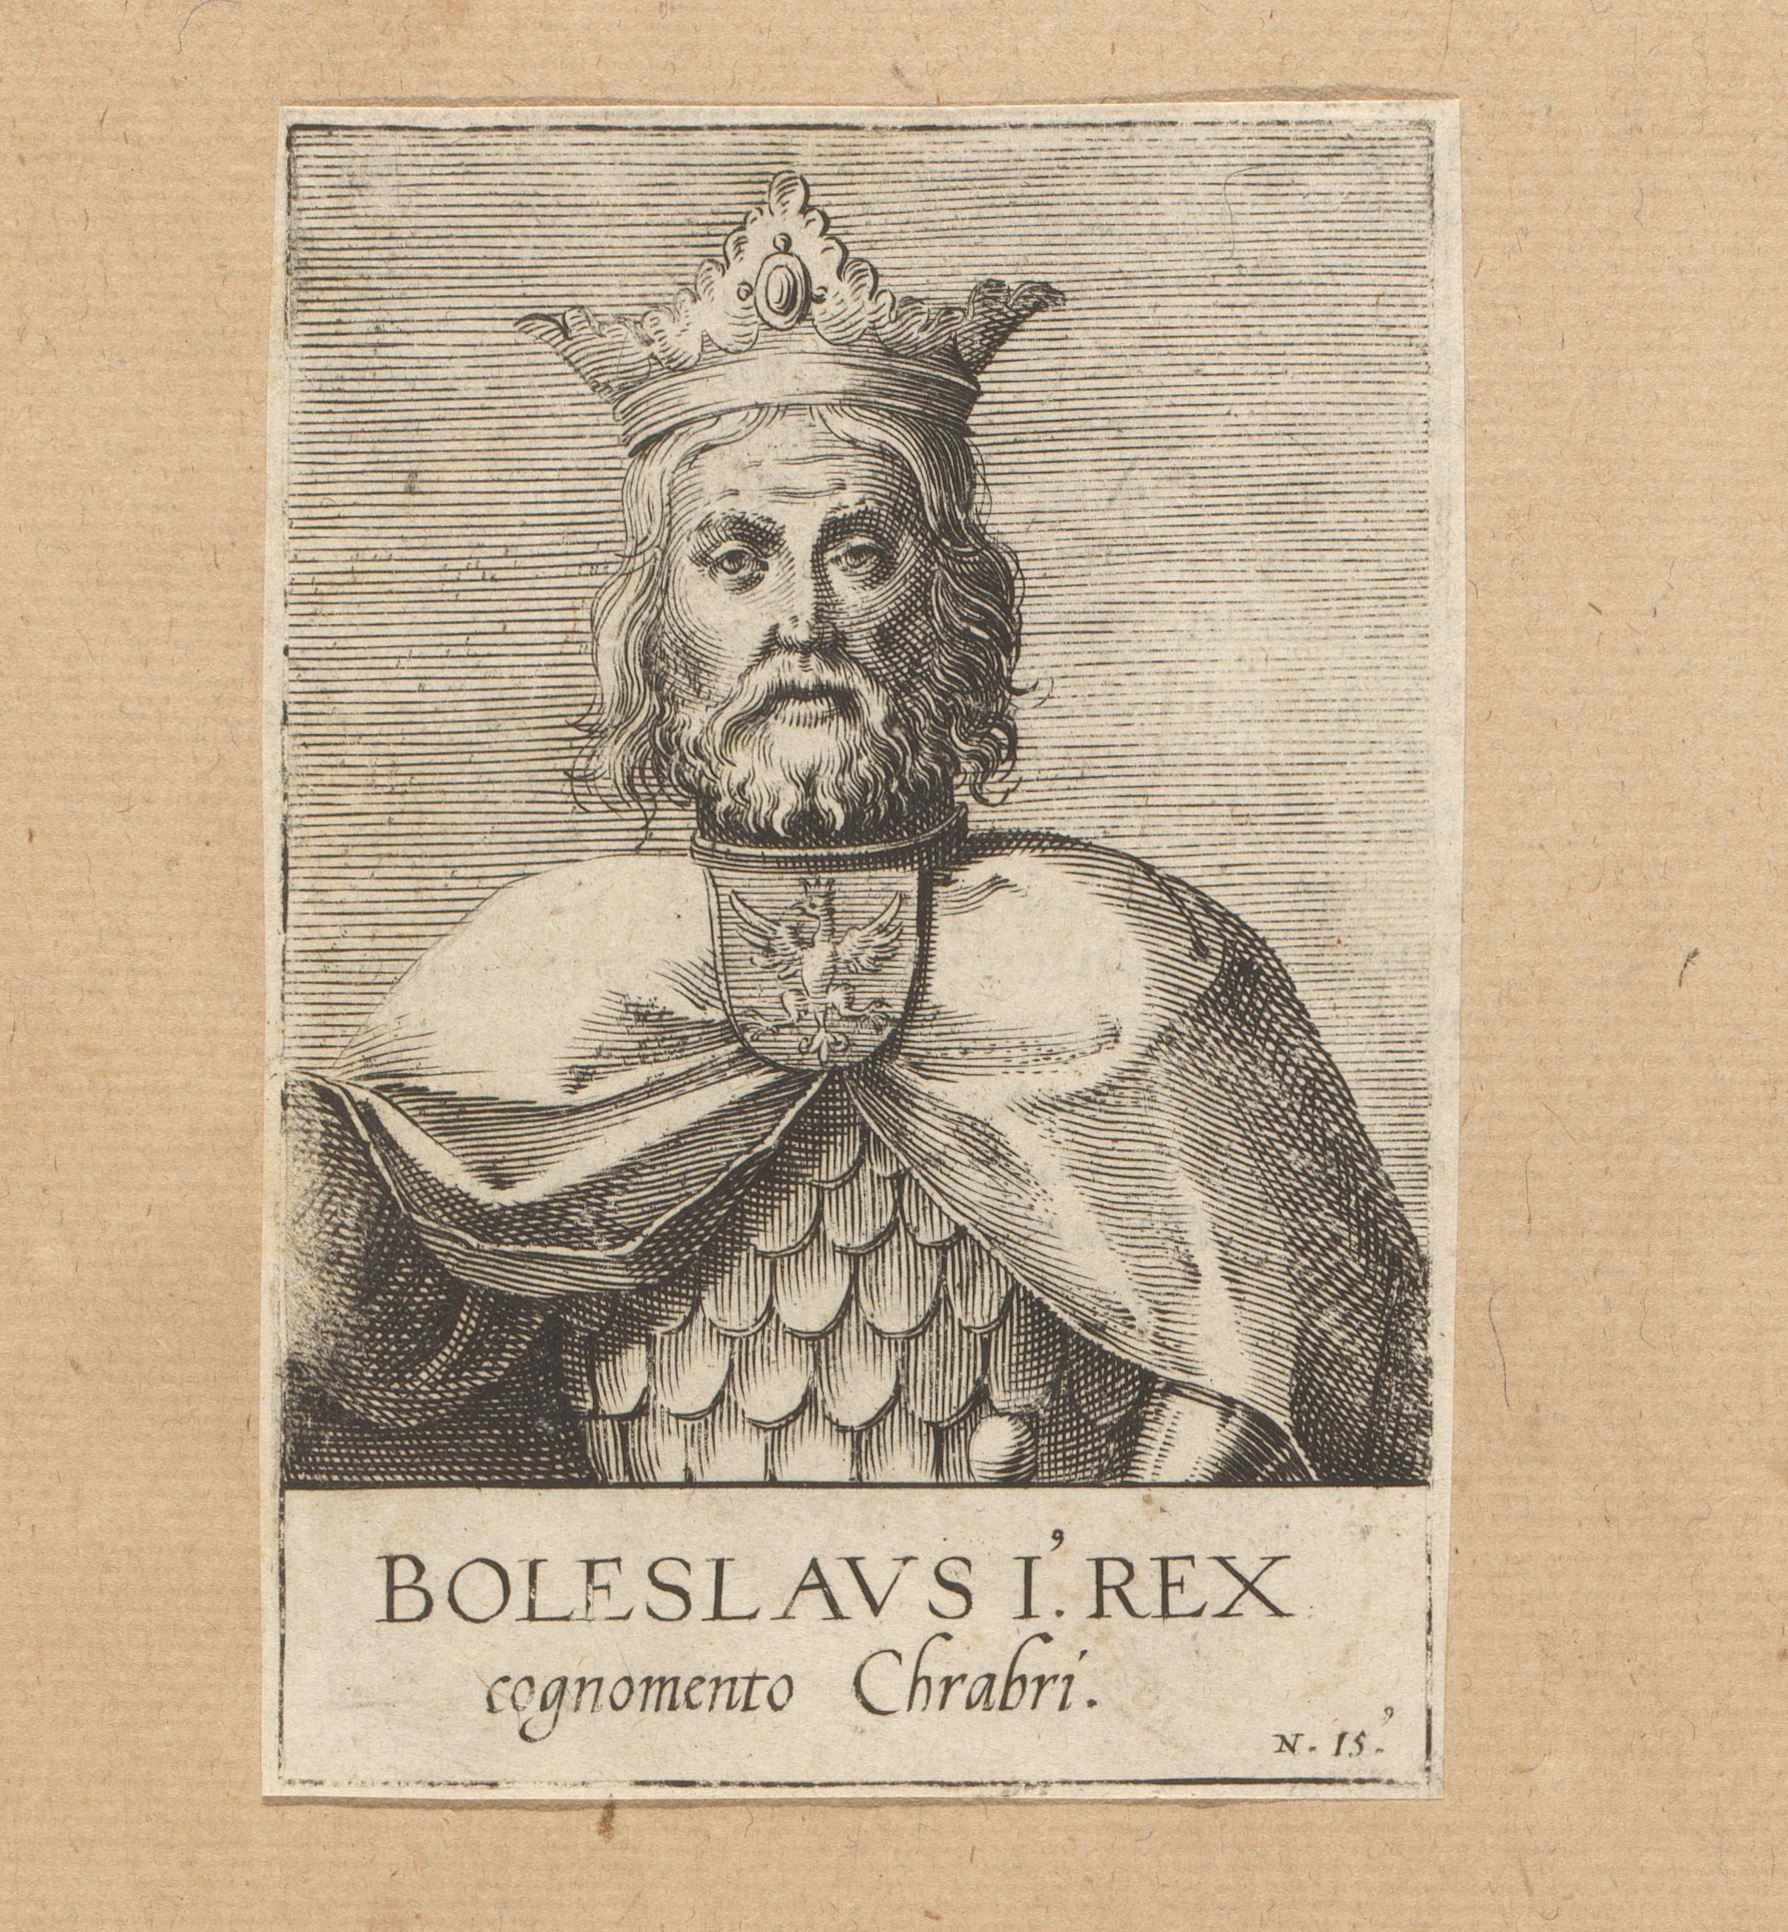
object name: print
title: Portret van Boleslaw I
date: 1574-1594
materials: paper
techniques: woodcut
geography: cologne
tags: historical persons, king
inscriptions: collector's mark: Lugt 240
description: Prent gebruikt in: Mylius, Arnold. Principum et Regum Polonorum Imagines ad Vivum Expressae (...). Keulen: Gottfried von Kempen, 1594.